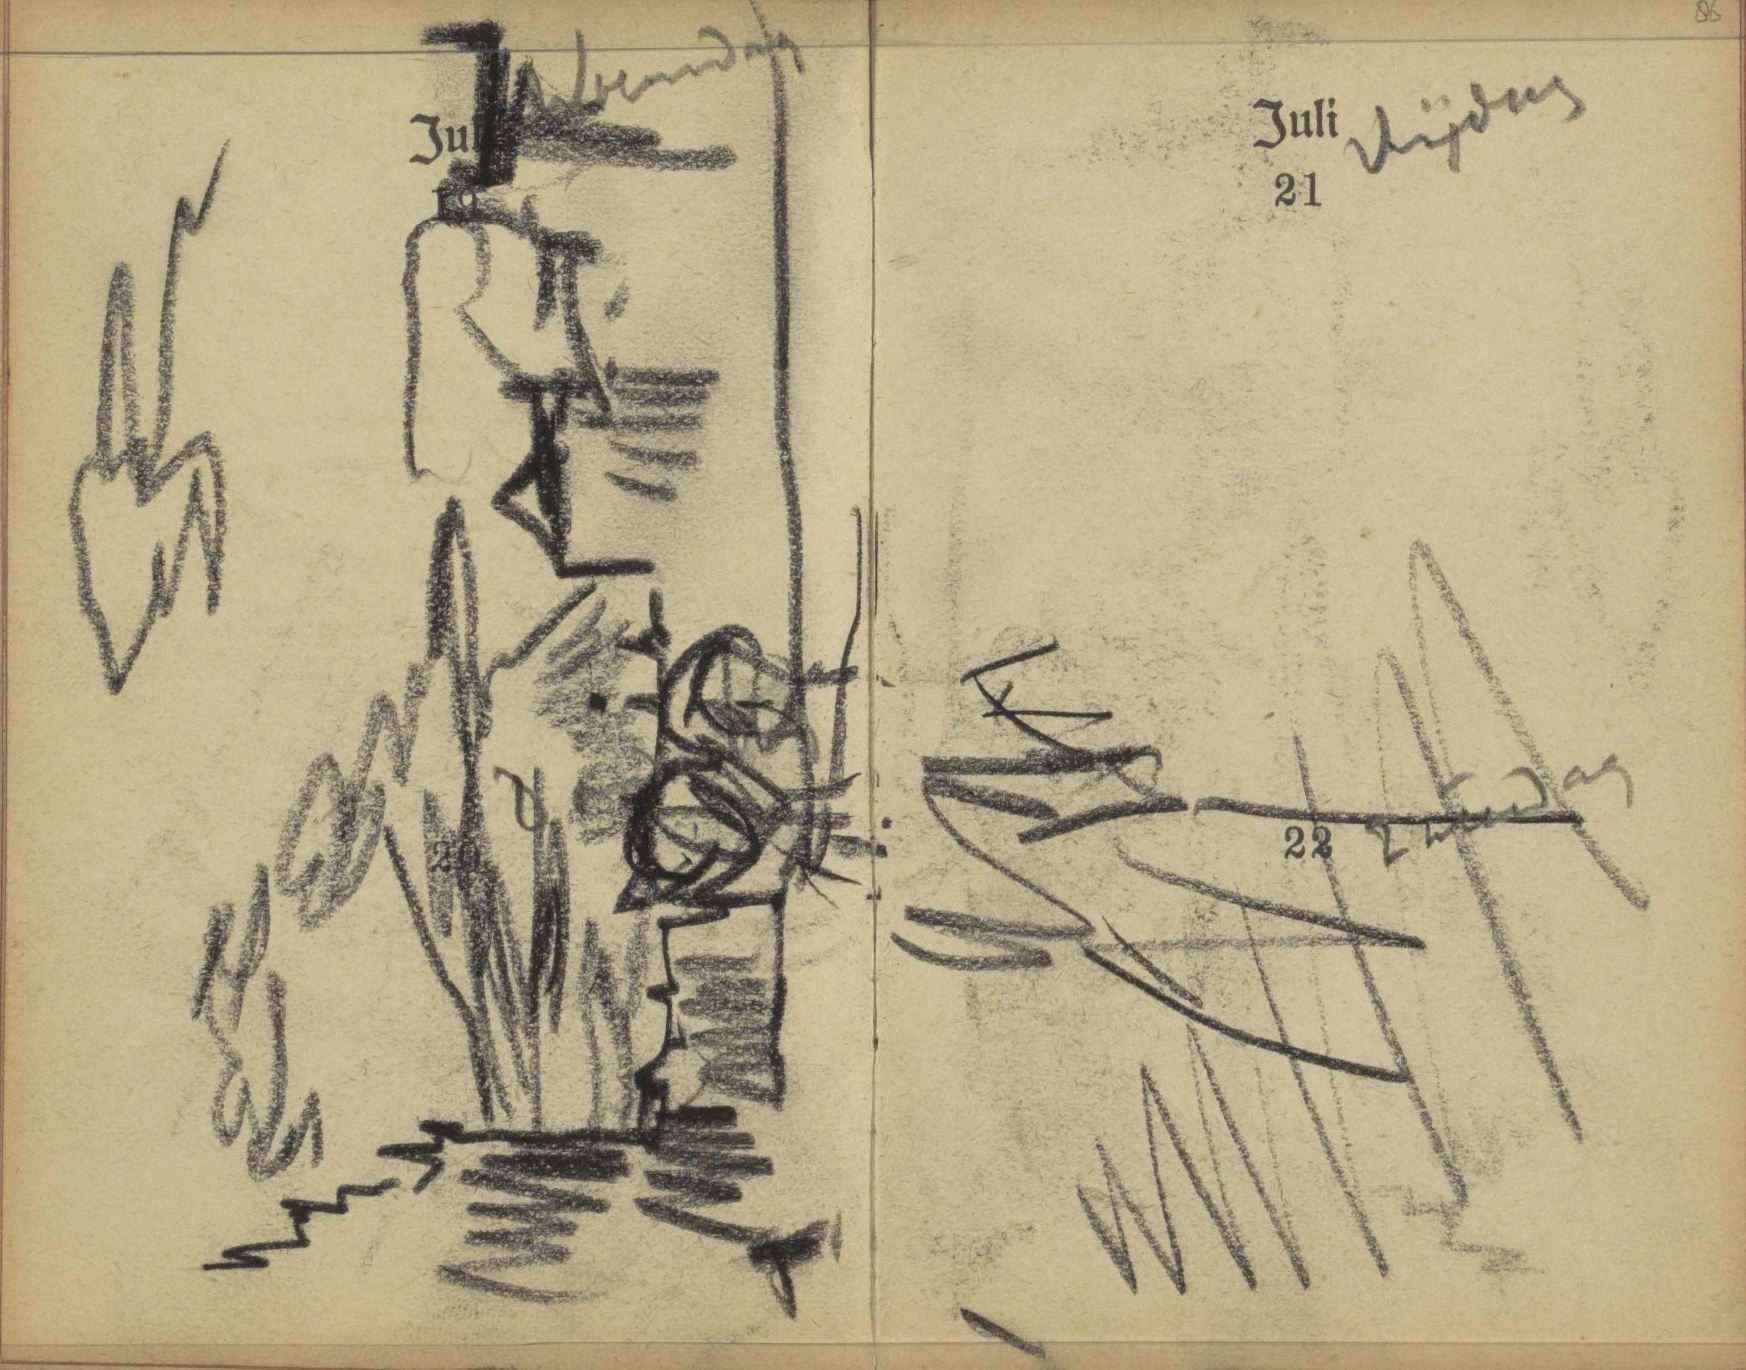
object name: sketchbook leaf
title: Gezicht in Amsterdam, mogelijk het Rokin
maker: george hendrik breitner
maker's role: draughtsman, painter, print maker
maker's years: 1857-1923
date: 1893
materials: chalk, paper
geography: amsterdam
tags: canals, waters (in city), adult woman (+ two persons), civic architecture; edifices; dwellings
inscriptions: annotation: ‘Woensdag/ Donderdag/ Vrijdag/ Zaterdag’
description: Vooraan twee vrouwen. Pagina 85 en pagina 86 uit een als schetsboek gebruikte agenda met 80 bladen.